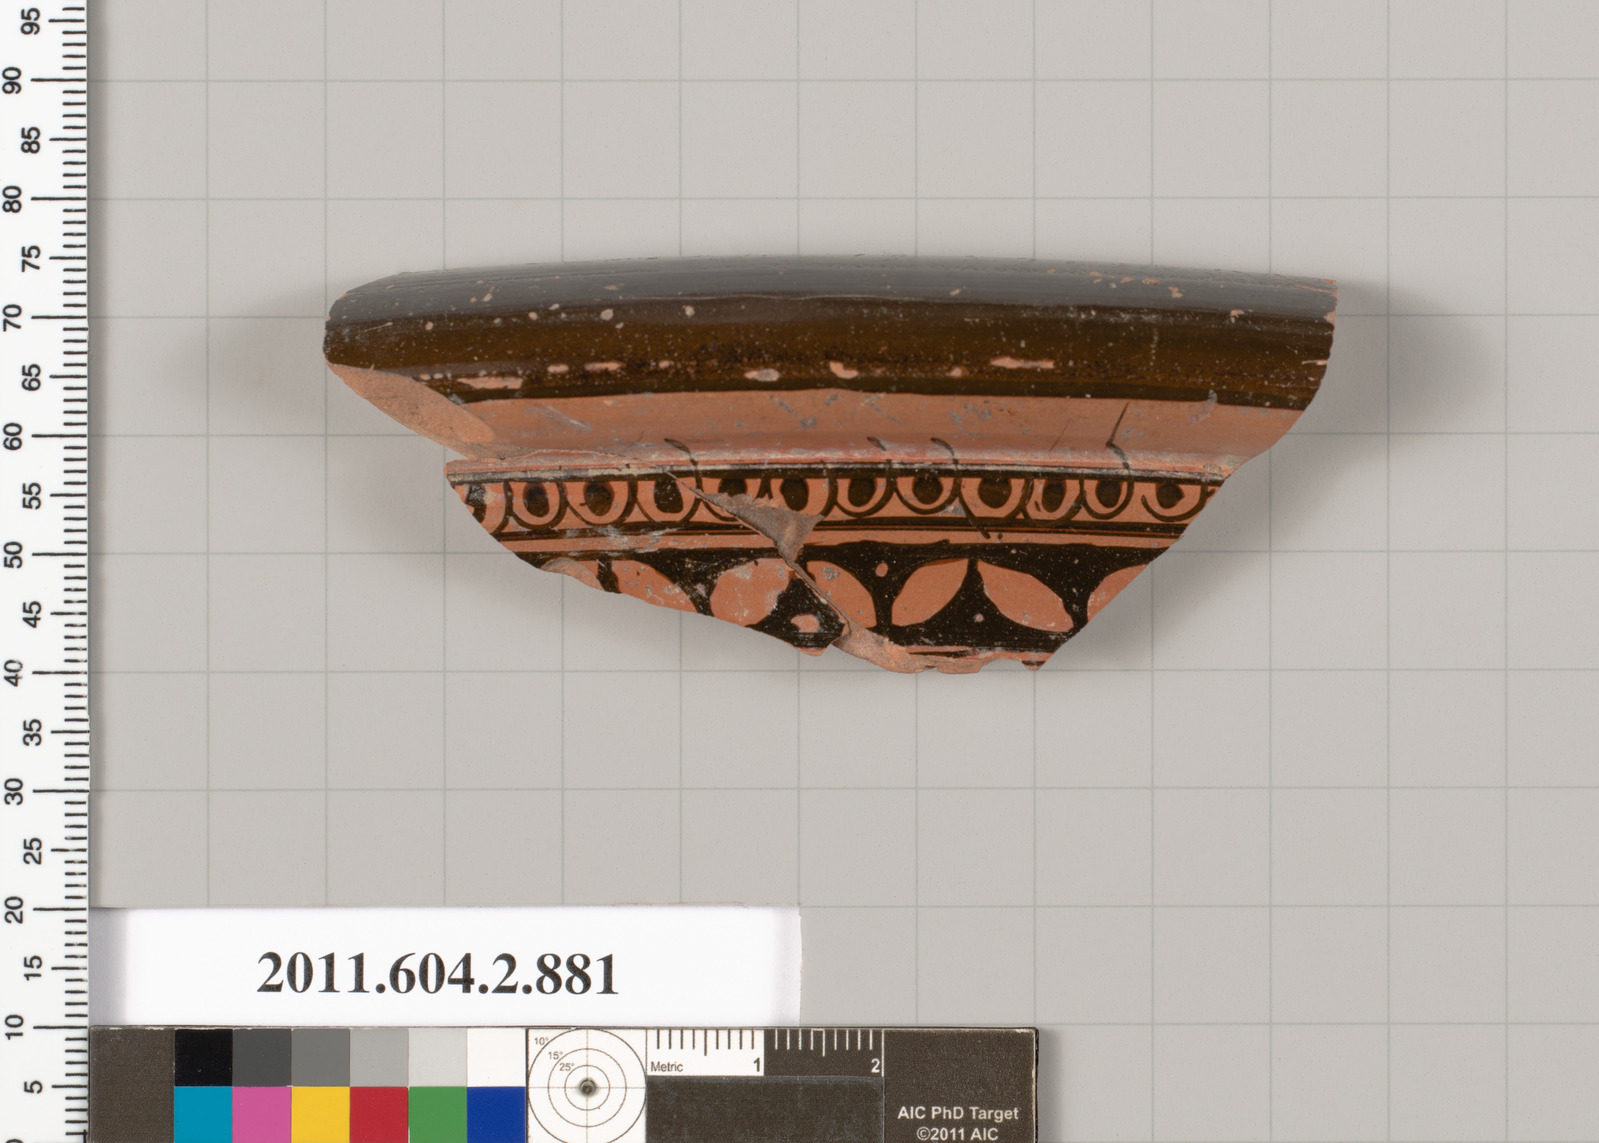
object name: bell krater fragment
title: Terracotta fragment of a bell-krater (bowl for mixing wine and water)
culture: greek, attic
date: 440 BCE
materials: terracotta